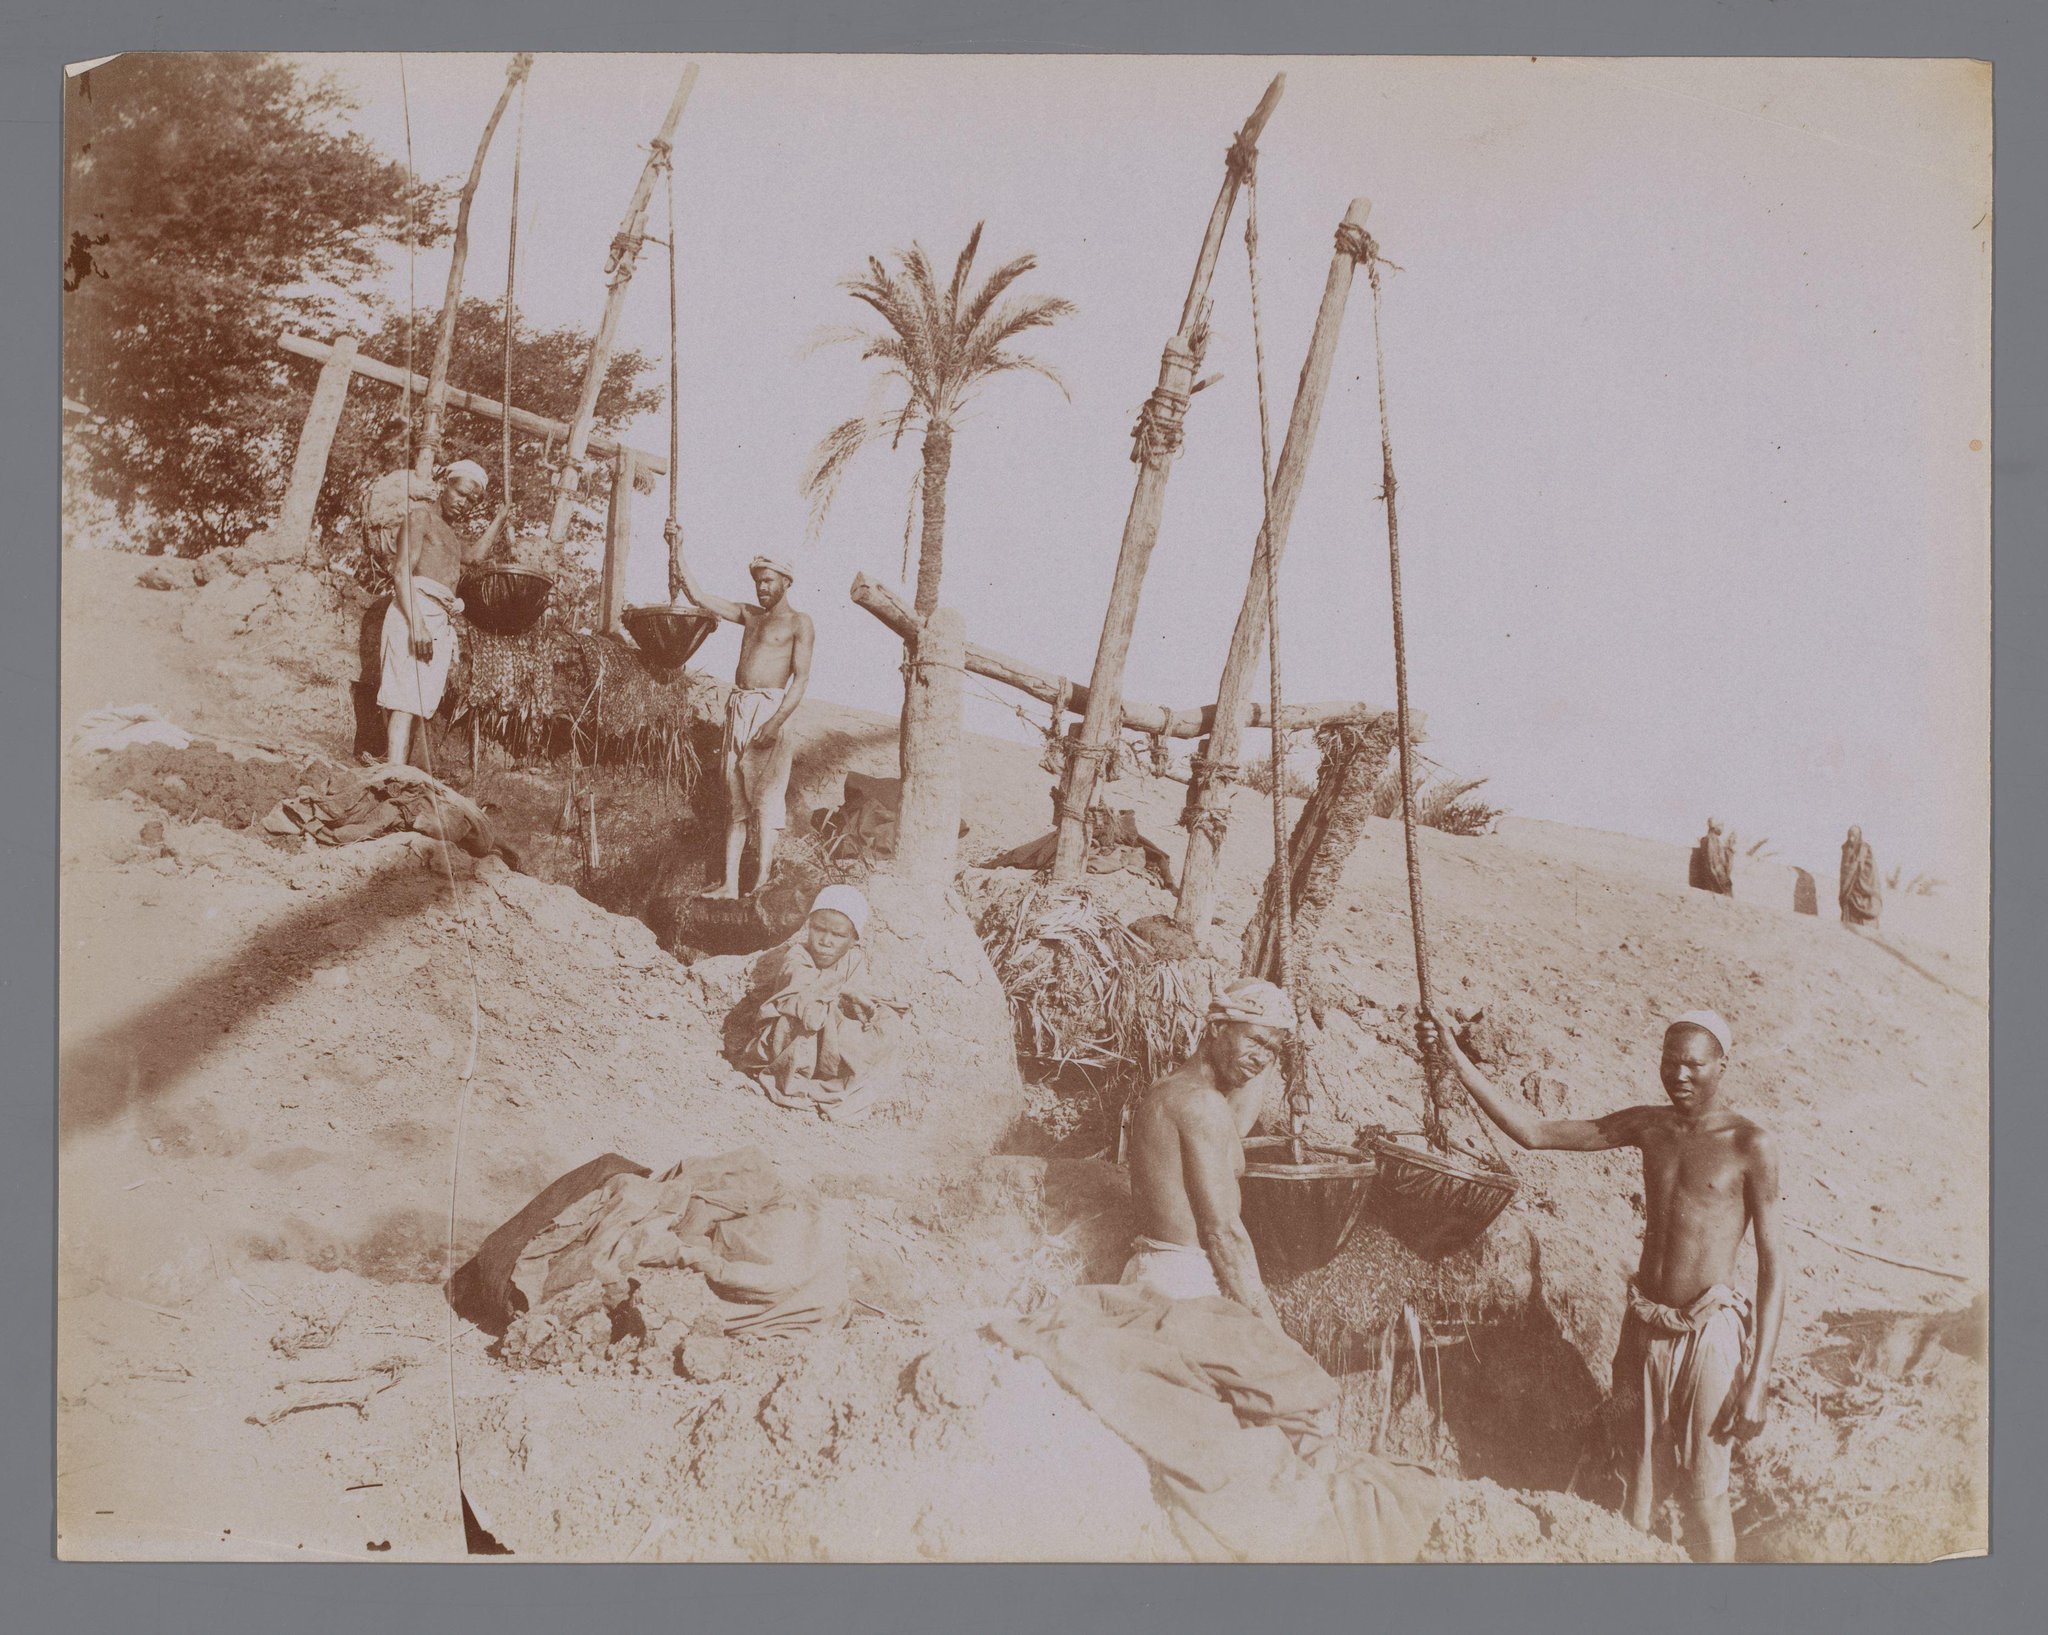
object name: photograph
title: Arbeiders tijdens de aanleg van een irrigatiekanaal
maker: Anonymous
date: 1860-1900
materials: paper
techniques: albumen print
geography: middle east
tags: irrigation ~ cultivation